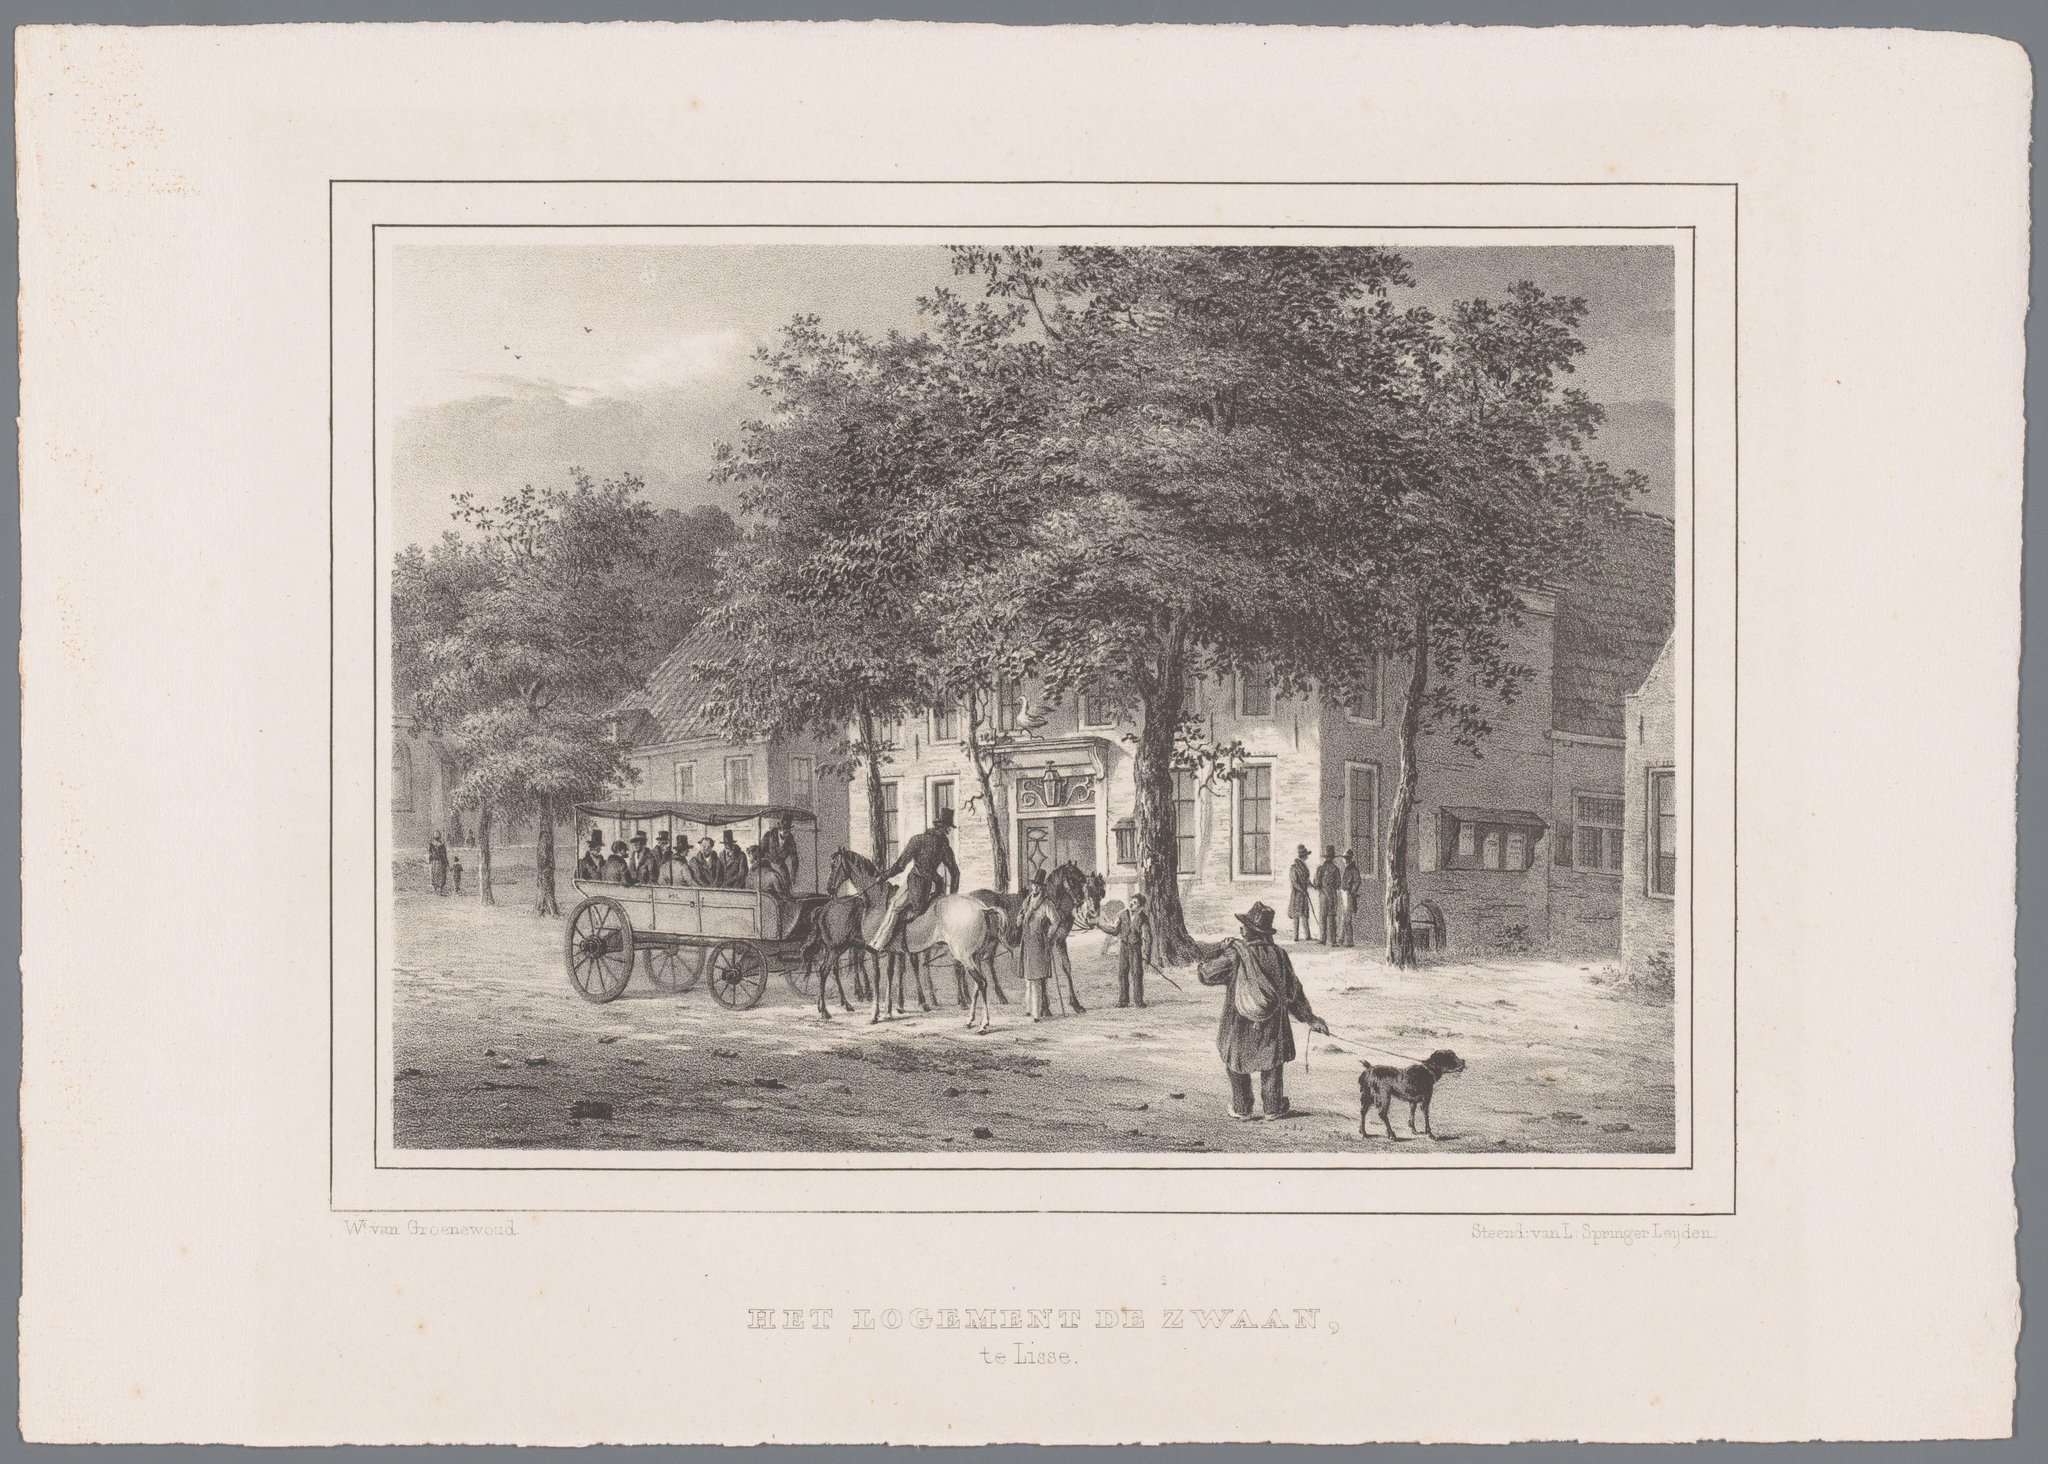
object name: print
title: Het Logement De Zwaan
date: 1843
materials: paper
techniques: lithograph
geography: leiden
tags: diligence, omnibus, horse-tram, hotel, hostelry, inn, leiden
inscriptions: collector's mark: Lugt 2228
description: Voor het hotel staat een paardentram vol met mensen. Deze prent maakt deel uit van een omslag met acht prenten.